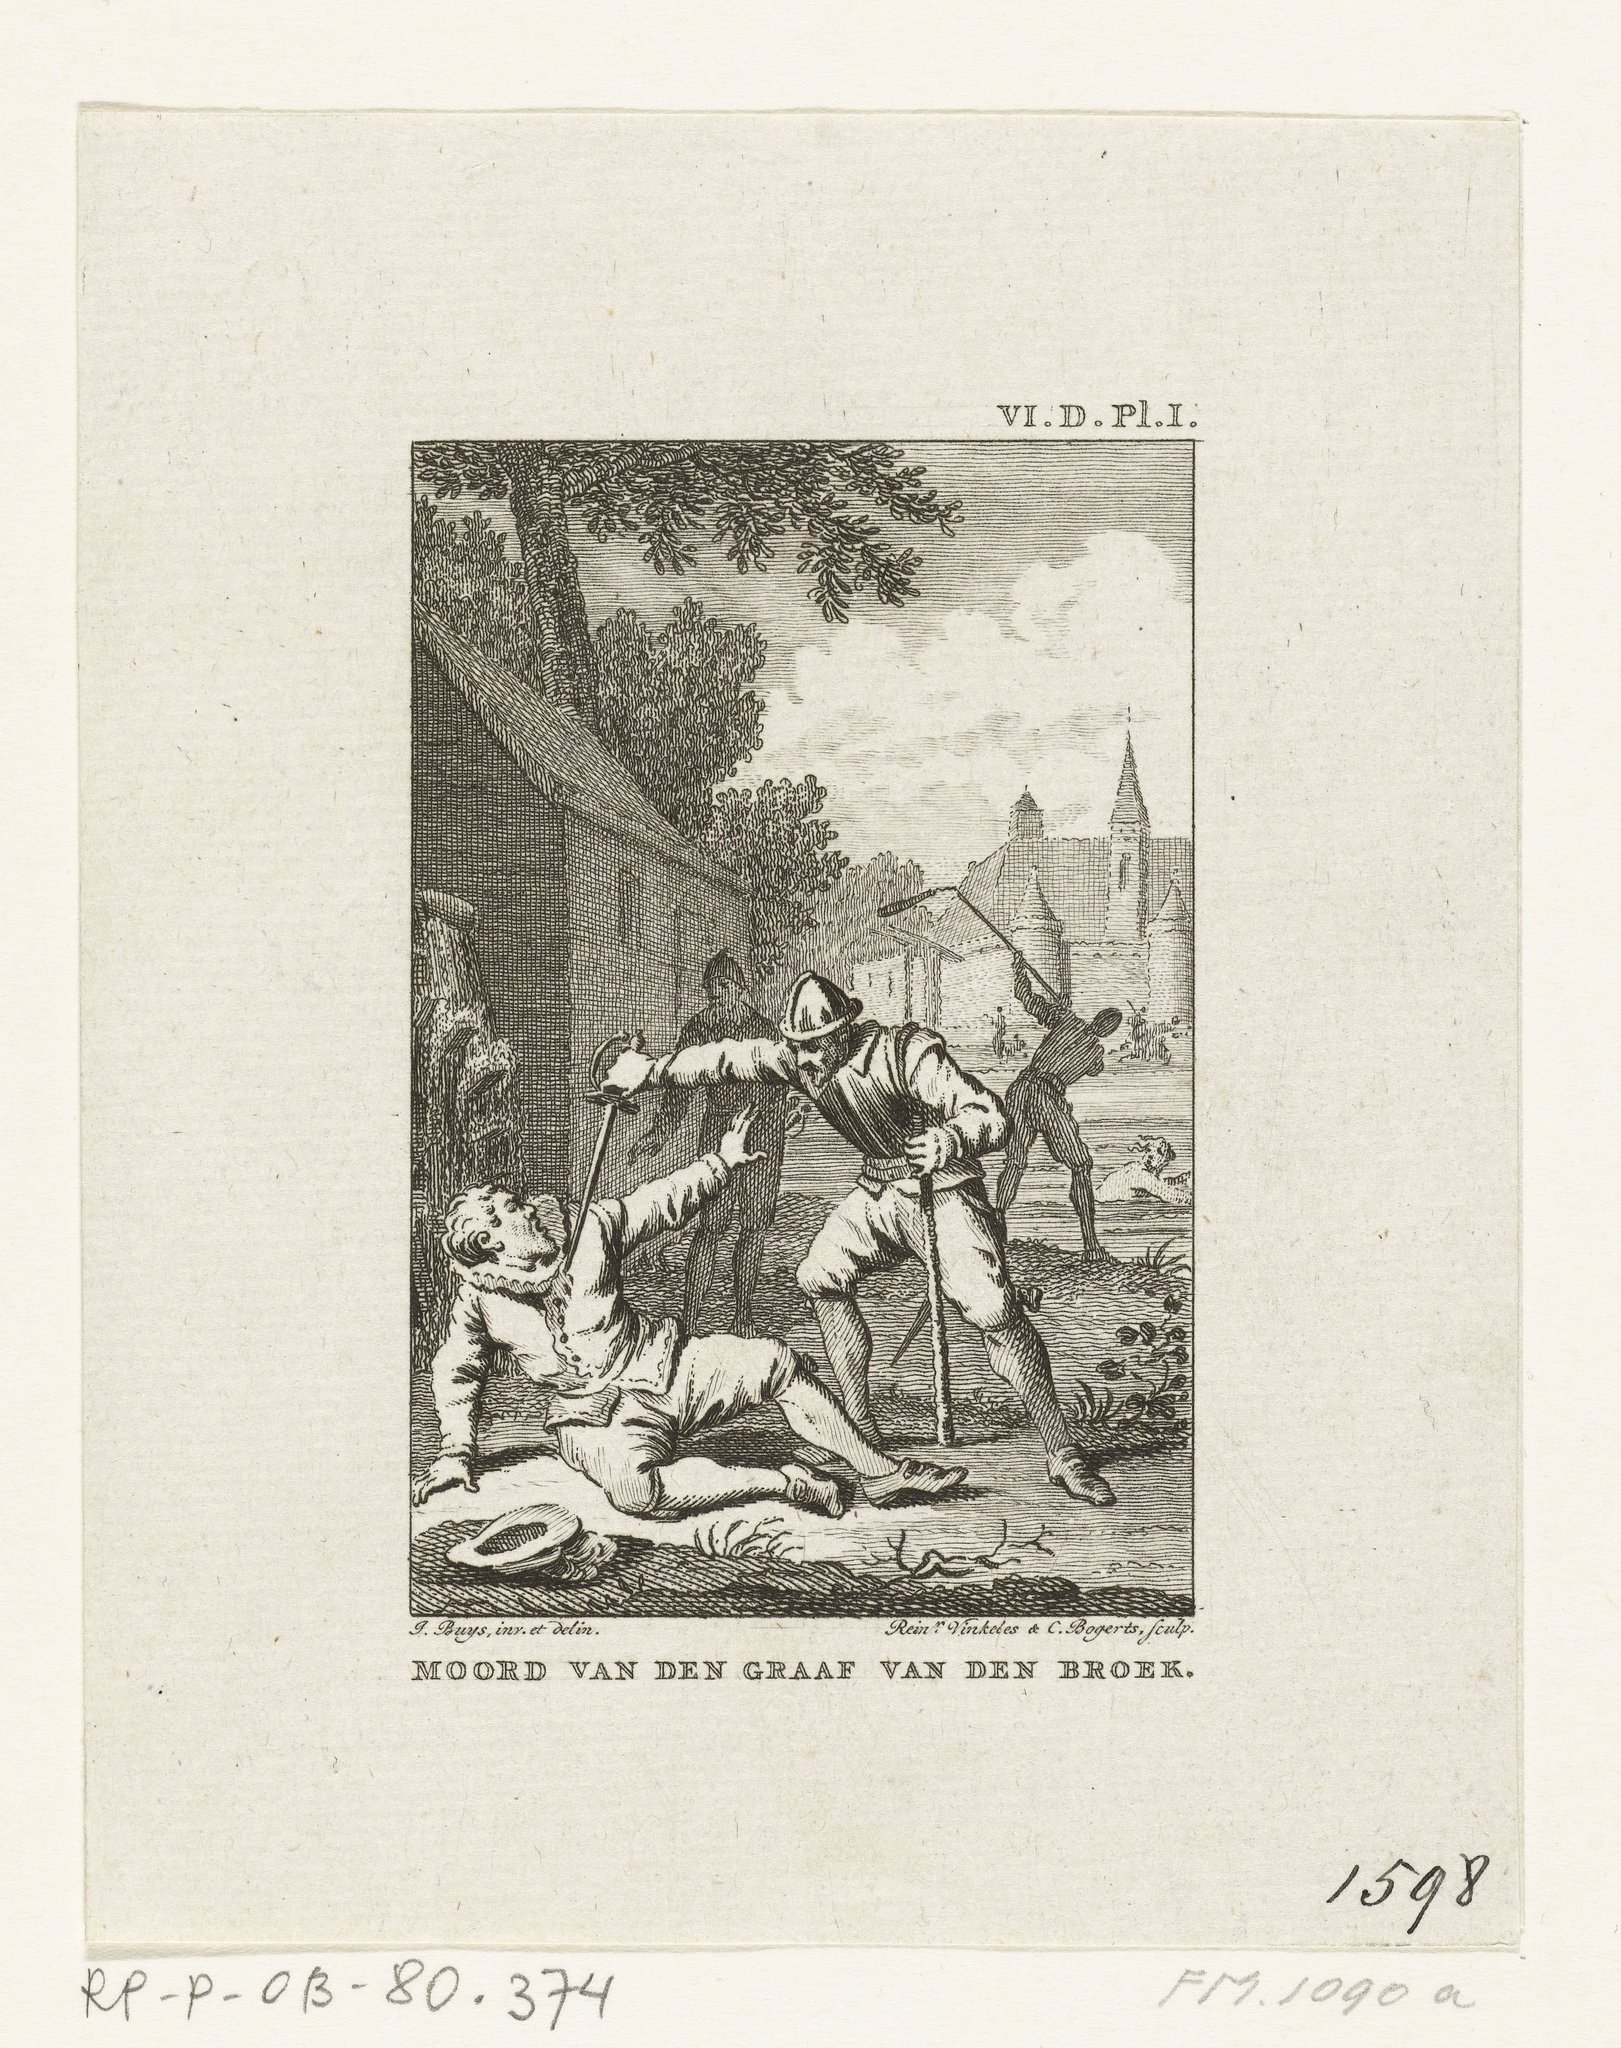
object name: history print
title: Moord van den graaf van den Broek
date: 1780-1795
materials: paper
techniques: etching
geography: northern netherlands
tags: violent death, being killed; being mishandled and maltreated; seeking death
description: Gebruikt als illustratie in: J. Fokke, Geschiedenissen der Vereenigde Nederlanden voor de vaderlandsche jeugd, Johannes Allart, Amsterdam 1783-1795, 25 delen, dl. VI, pl. I.